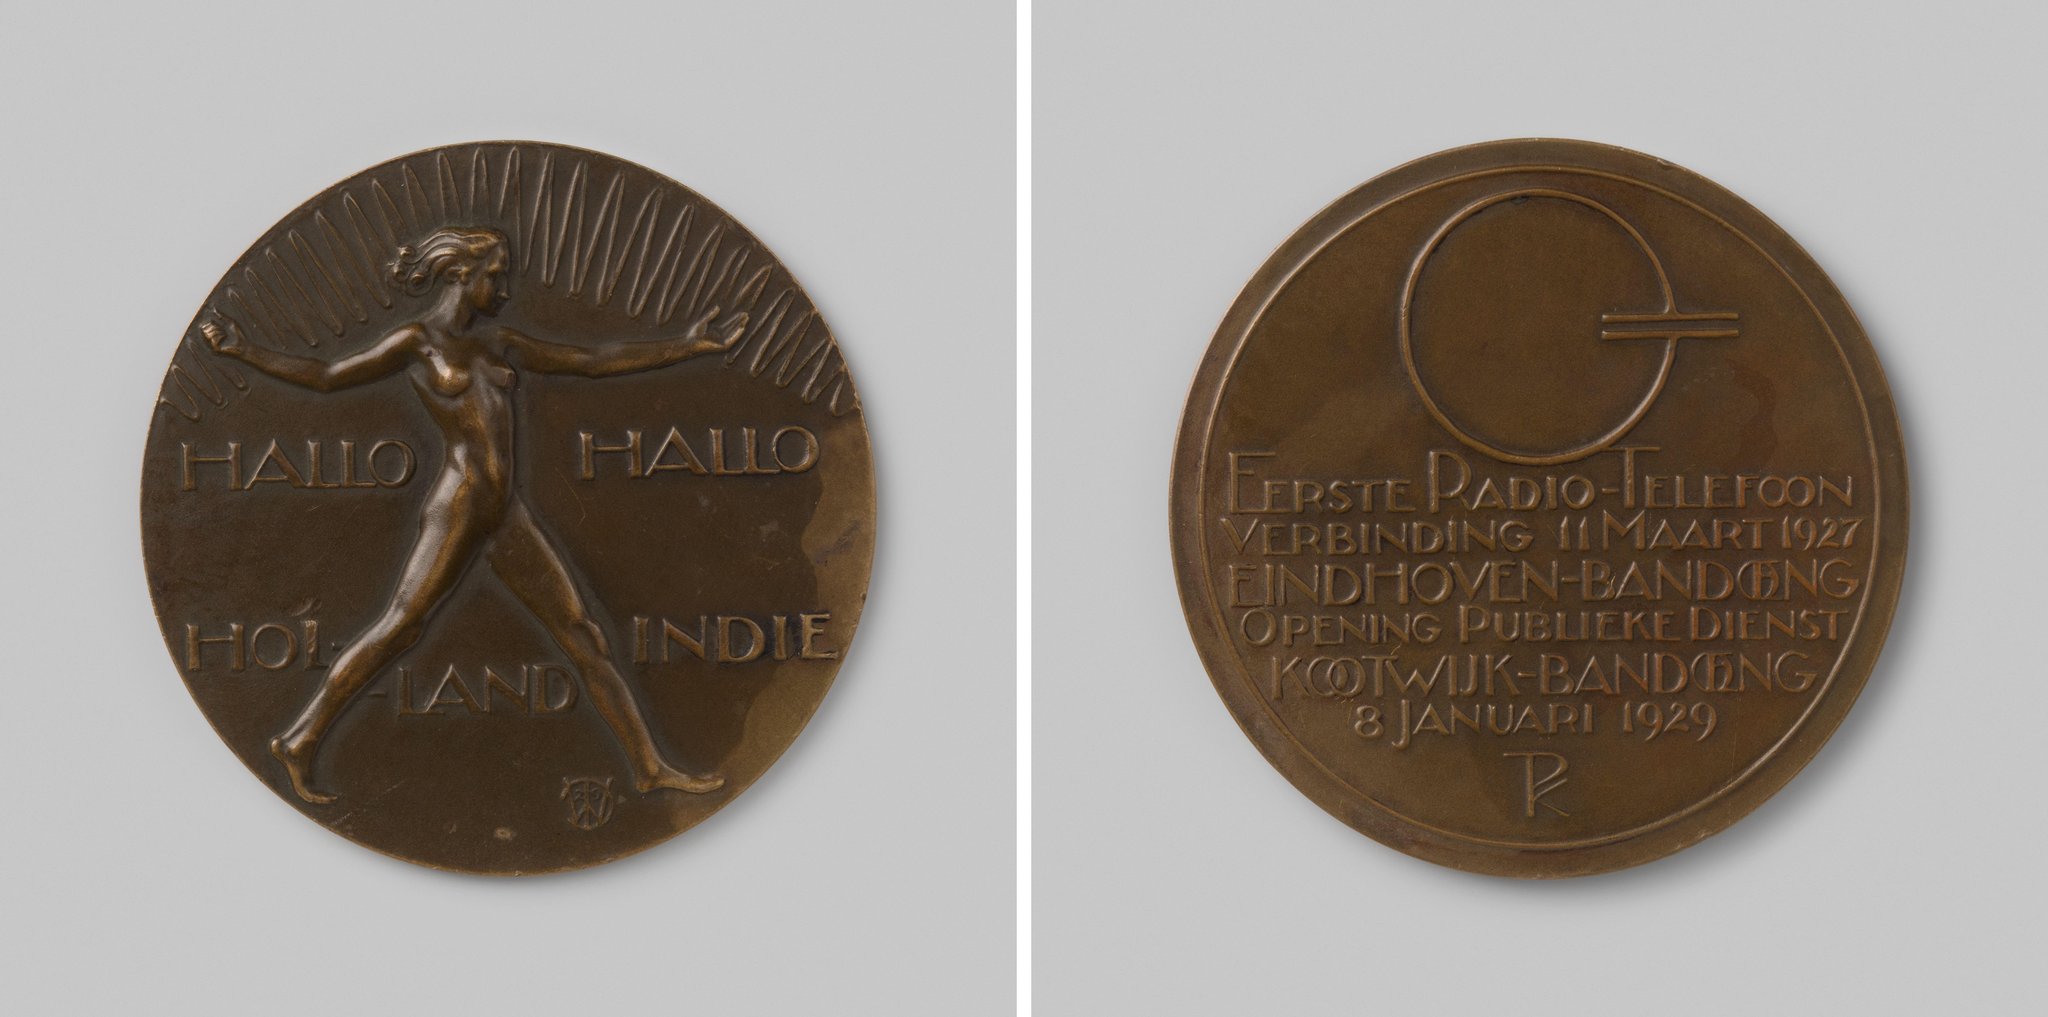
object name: history medal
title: Eerste radiotelefonische verbinding tussen Nederland en Nederlandsch-Indië en opening van een publieke dienst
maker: dirk wolbers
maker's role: designer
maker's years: 1890-1957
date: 1929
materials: bronze, cardboard, velvet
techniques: casting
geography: voorschoten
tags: bandung, eindhoven, kootwijk